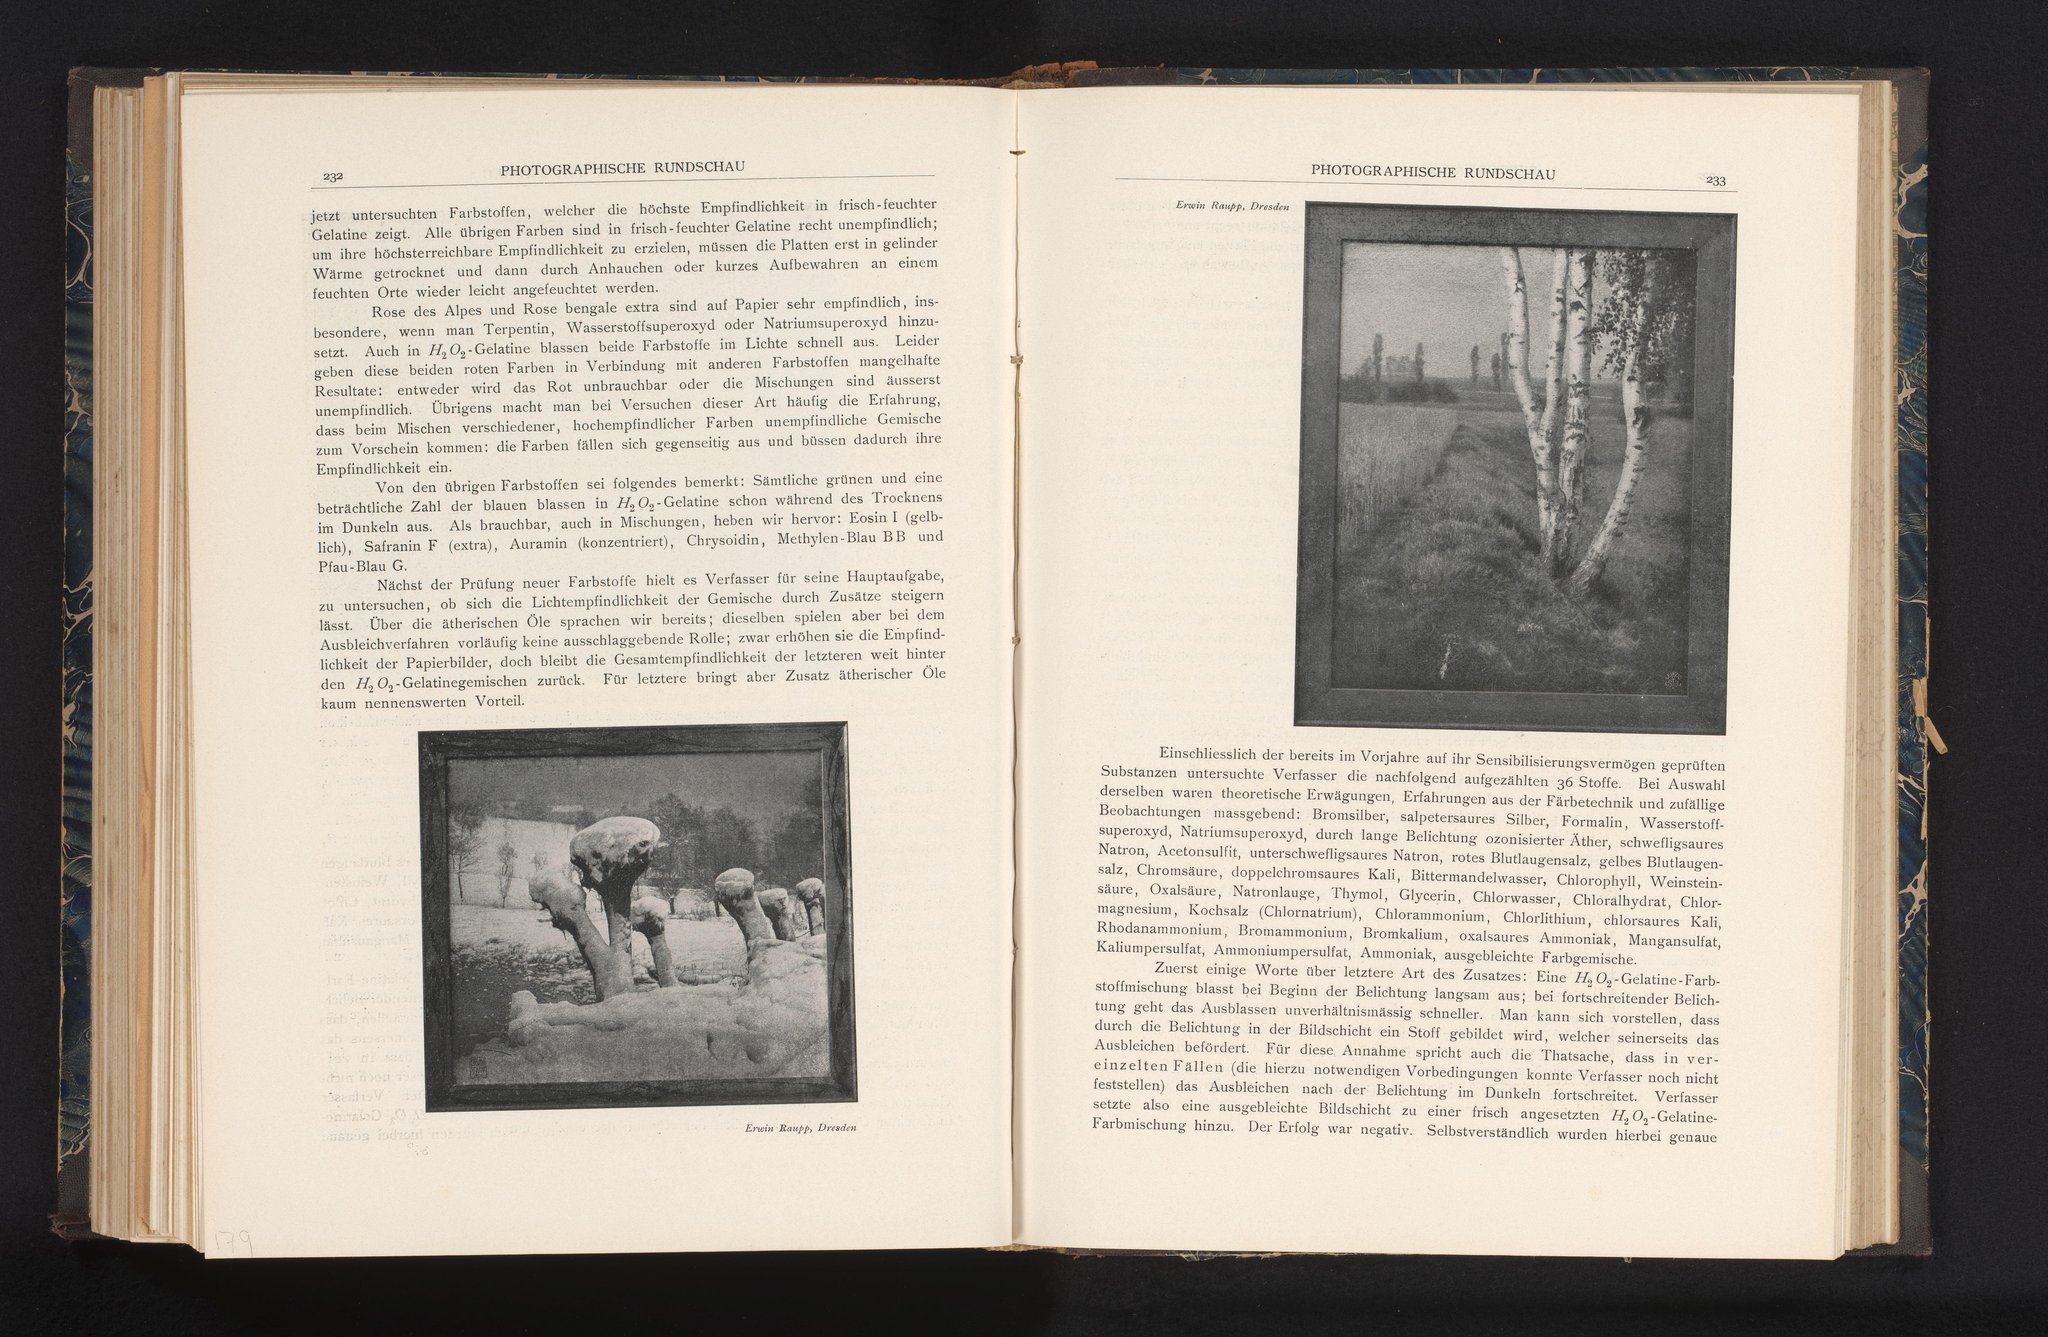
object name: page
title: Gezicht een boom in een landschap in een lijst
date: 1897-1902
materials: paper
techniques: autotype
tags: trees, landscapes, frame of painting, etc.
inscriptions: monogram: ‘Leipzig/ S.G.’